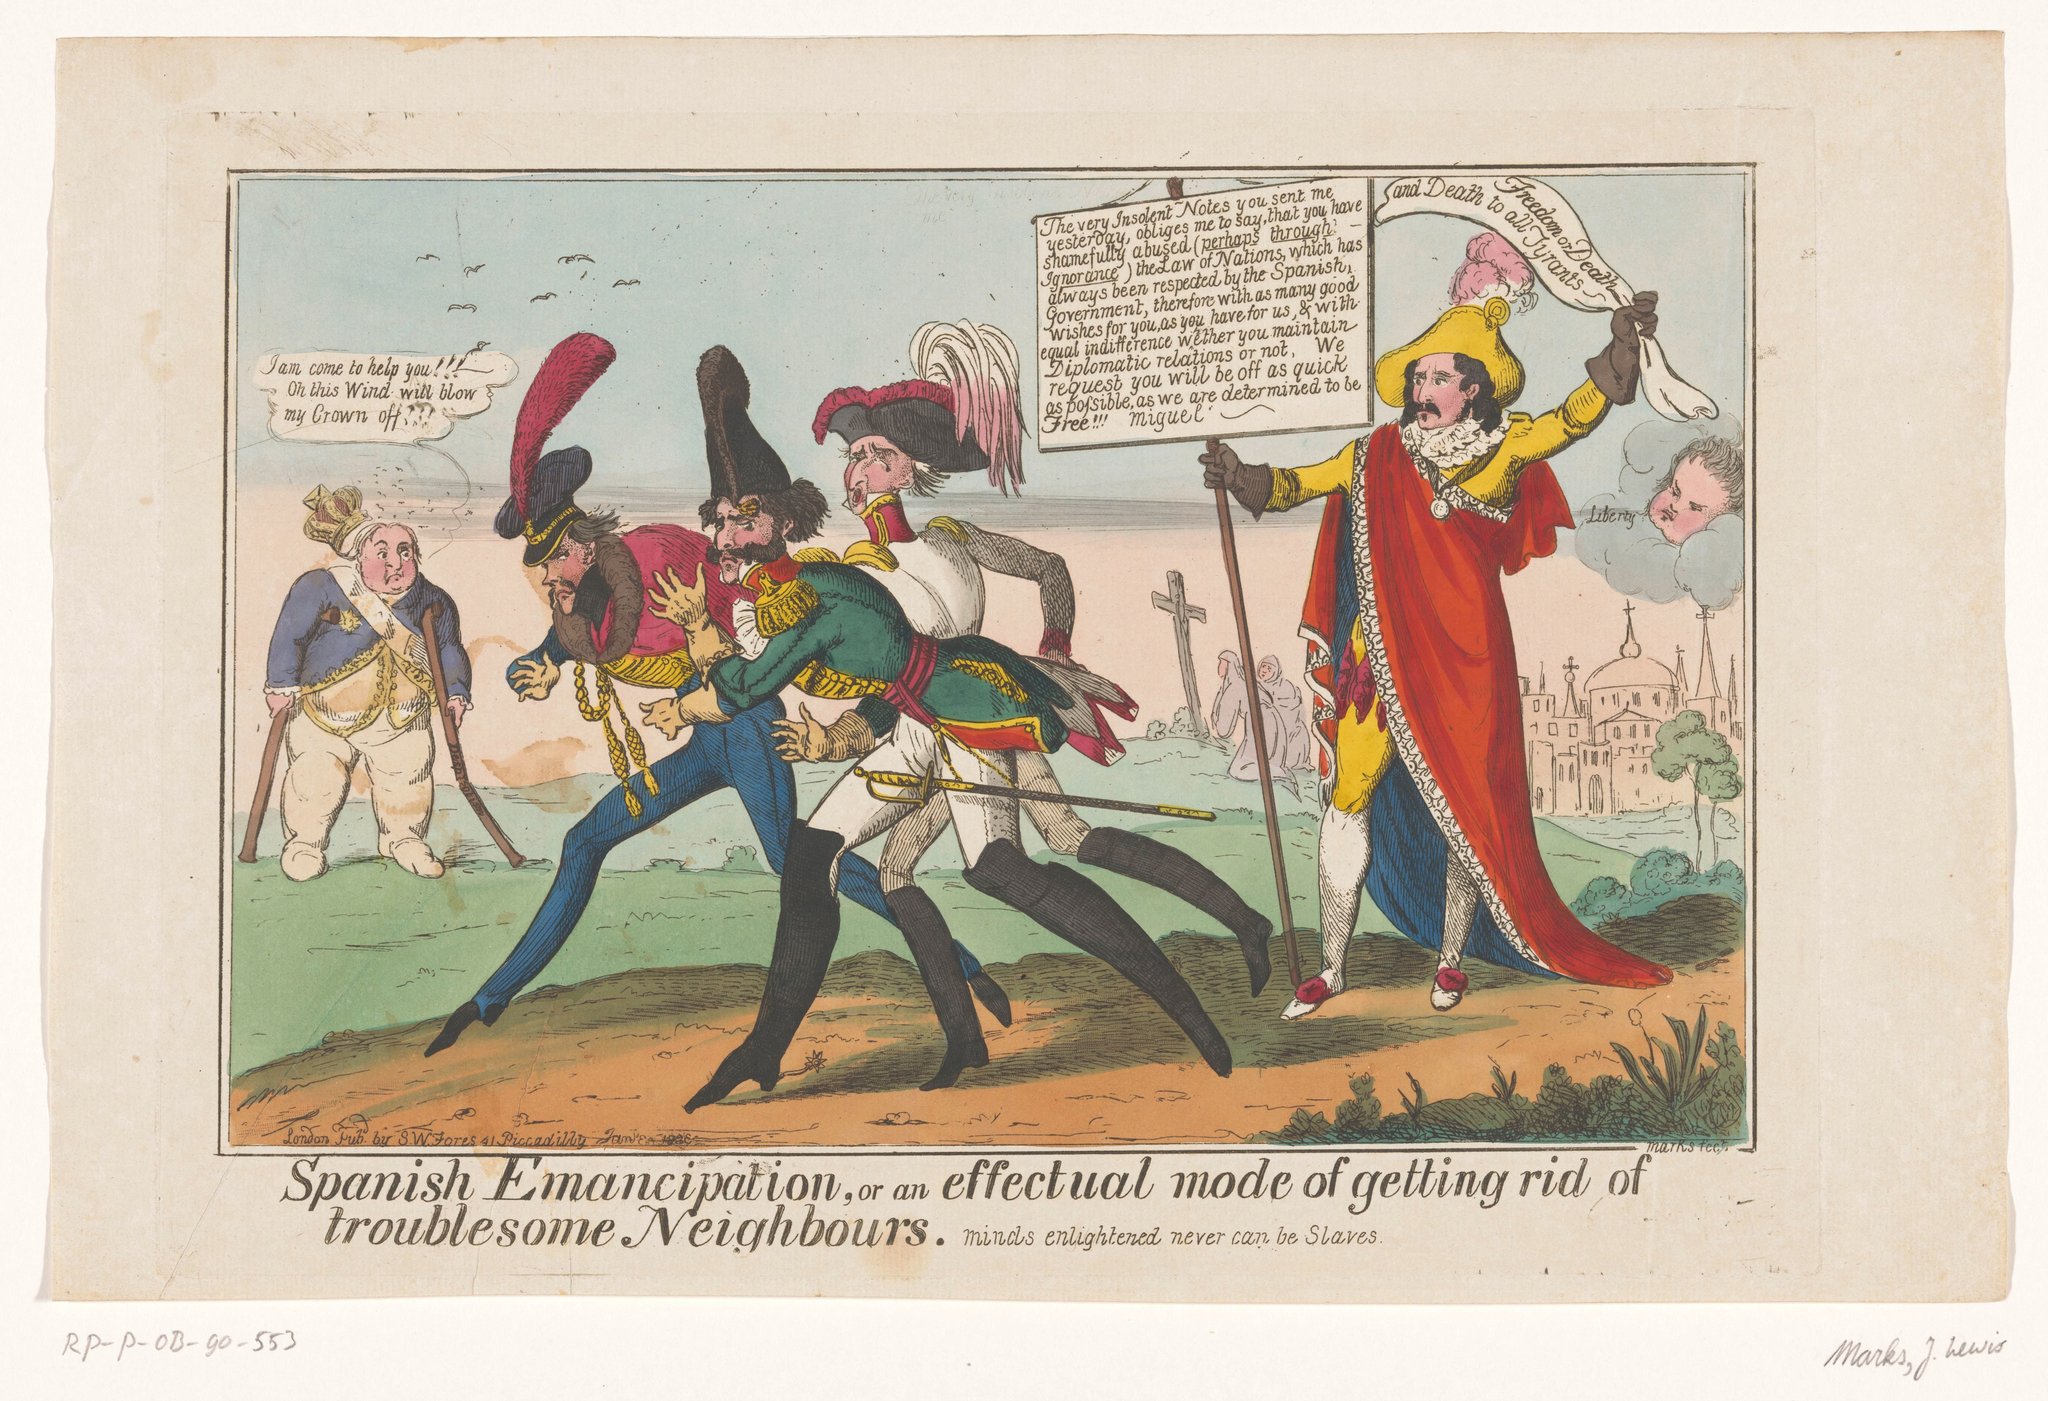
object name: cartoon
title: Spanish emancipation, or an effectual mode of getting rid of troublesome neighbours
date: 1823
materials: paper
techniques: etching, hand coloring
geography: england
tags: paris, lodewijk xviii (koning van frankrijk), political caricatures and satires, spain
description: Spotprent waarin de Oostenrijkse, Pruisische en Russische ambassadeurs door de leider van de Spaanse regering in Madrid, Evaristo Miguel, het land uitgestuurd, 1823. Op de achtergrond kijkt de Frans koning Lodewijk XVIII met krukken toe.